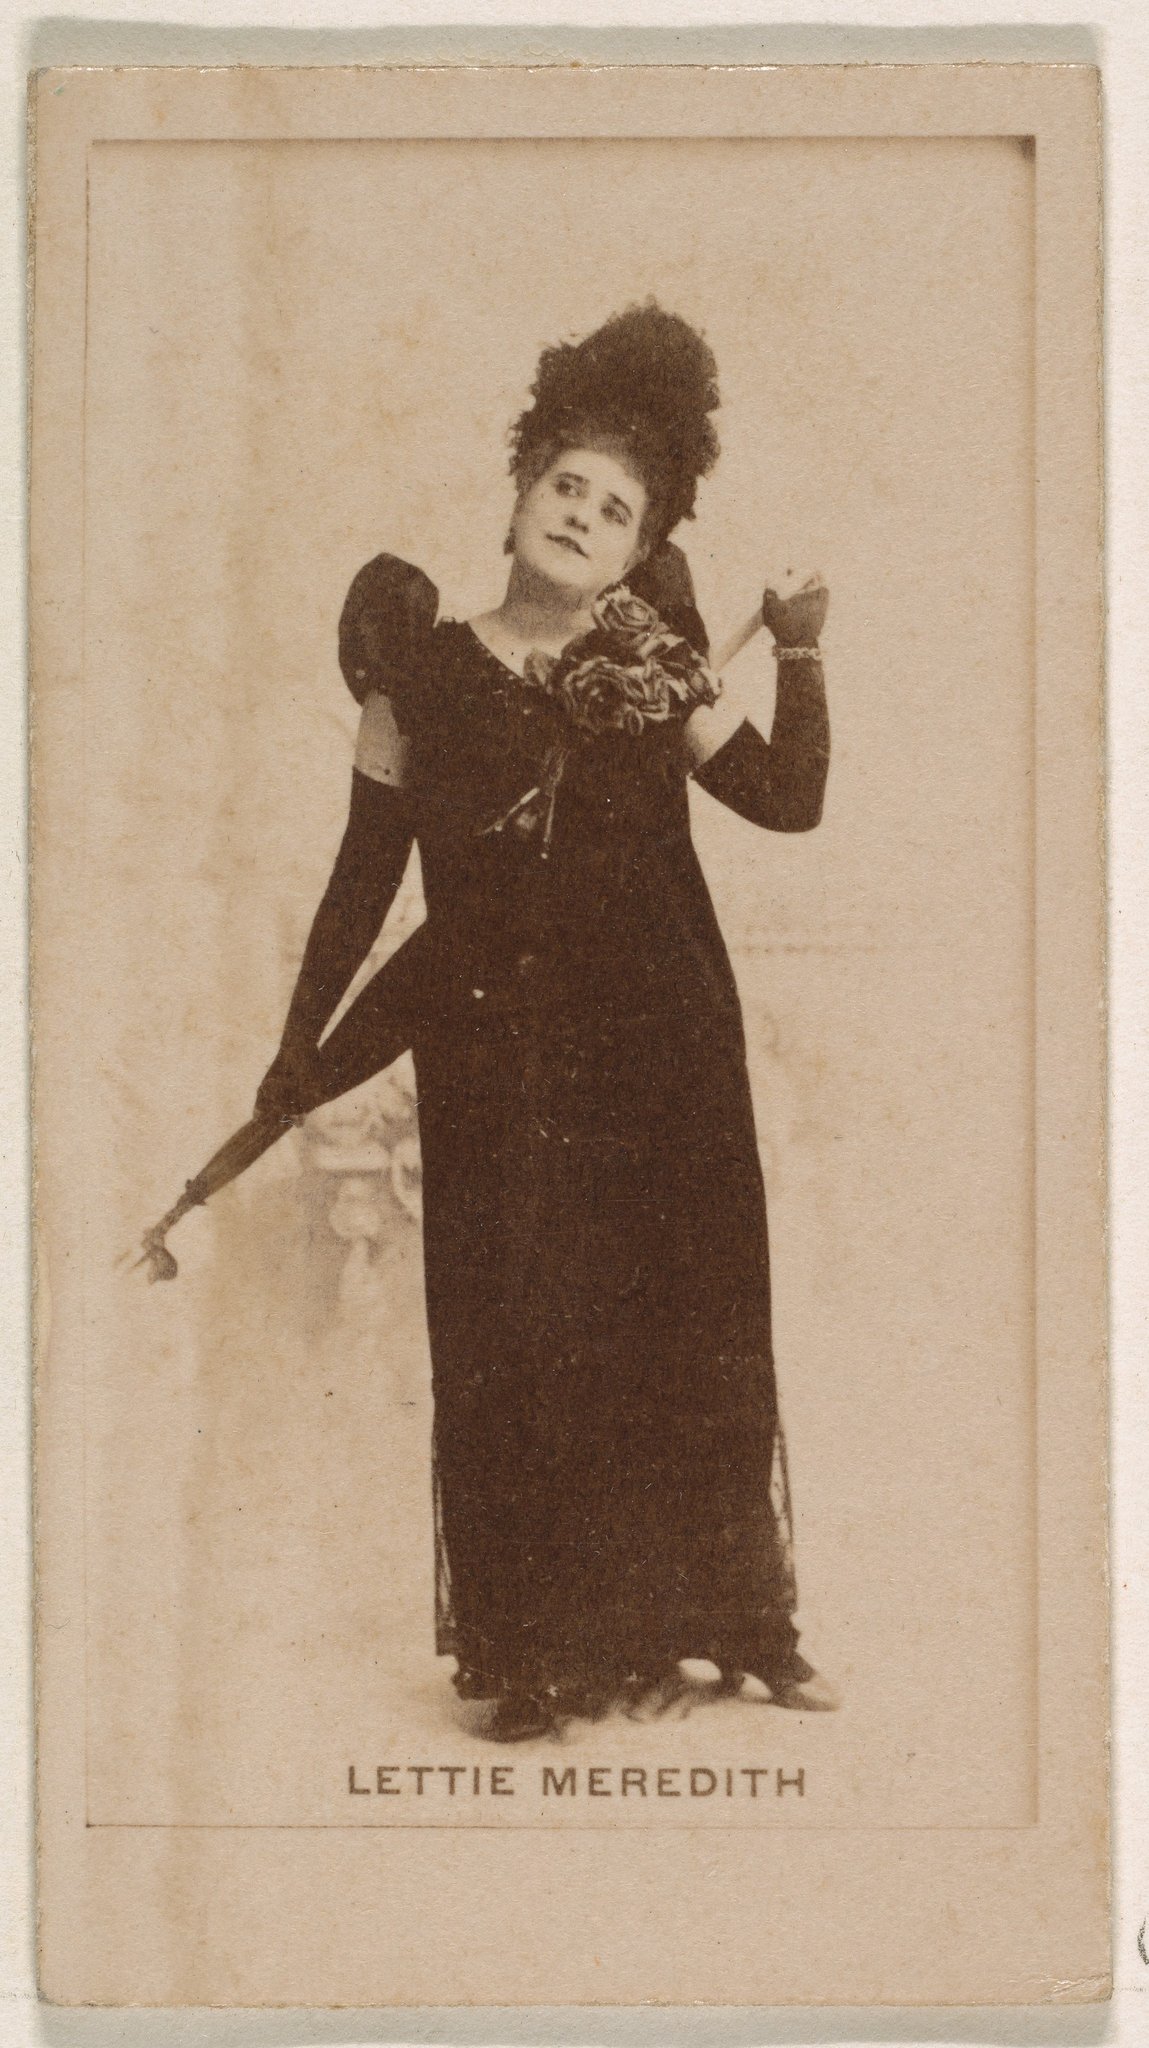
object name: photograph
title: Lettie Meredith, from the Actresses series (N245) issued by Kinney Brothers to promote Sweet Caporal Cigarettes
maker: kinney brothers tobacco company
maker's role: publisher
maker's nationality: american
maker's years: 1869-2011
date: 1890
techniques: albumen silver print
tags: portraits,women,actresses